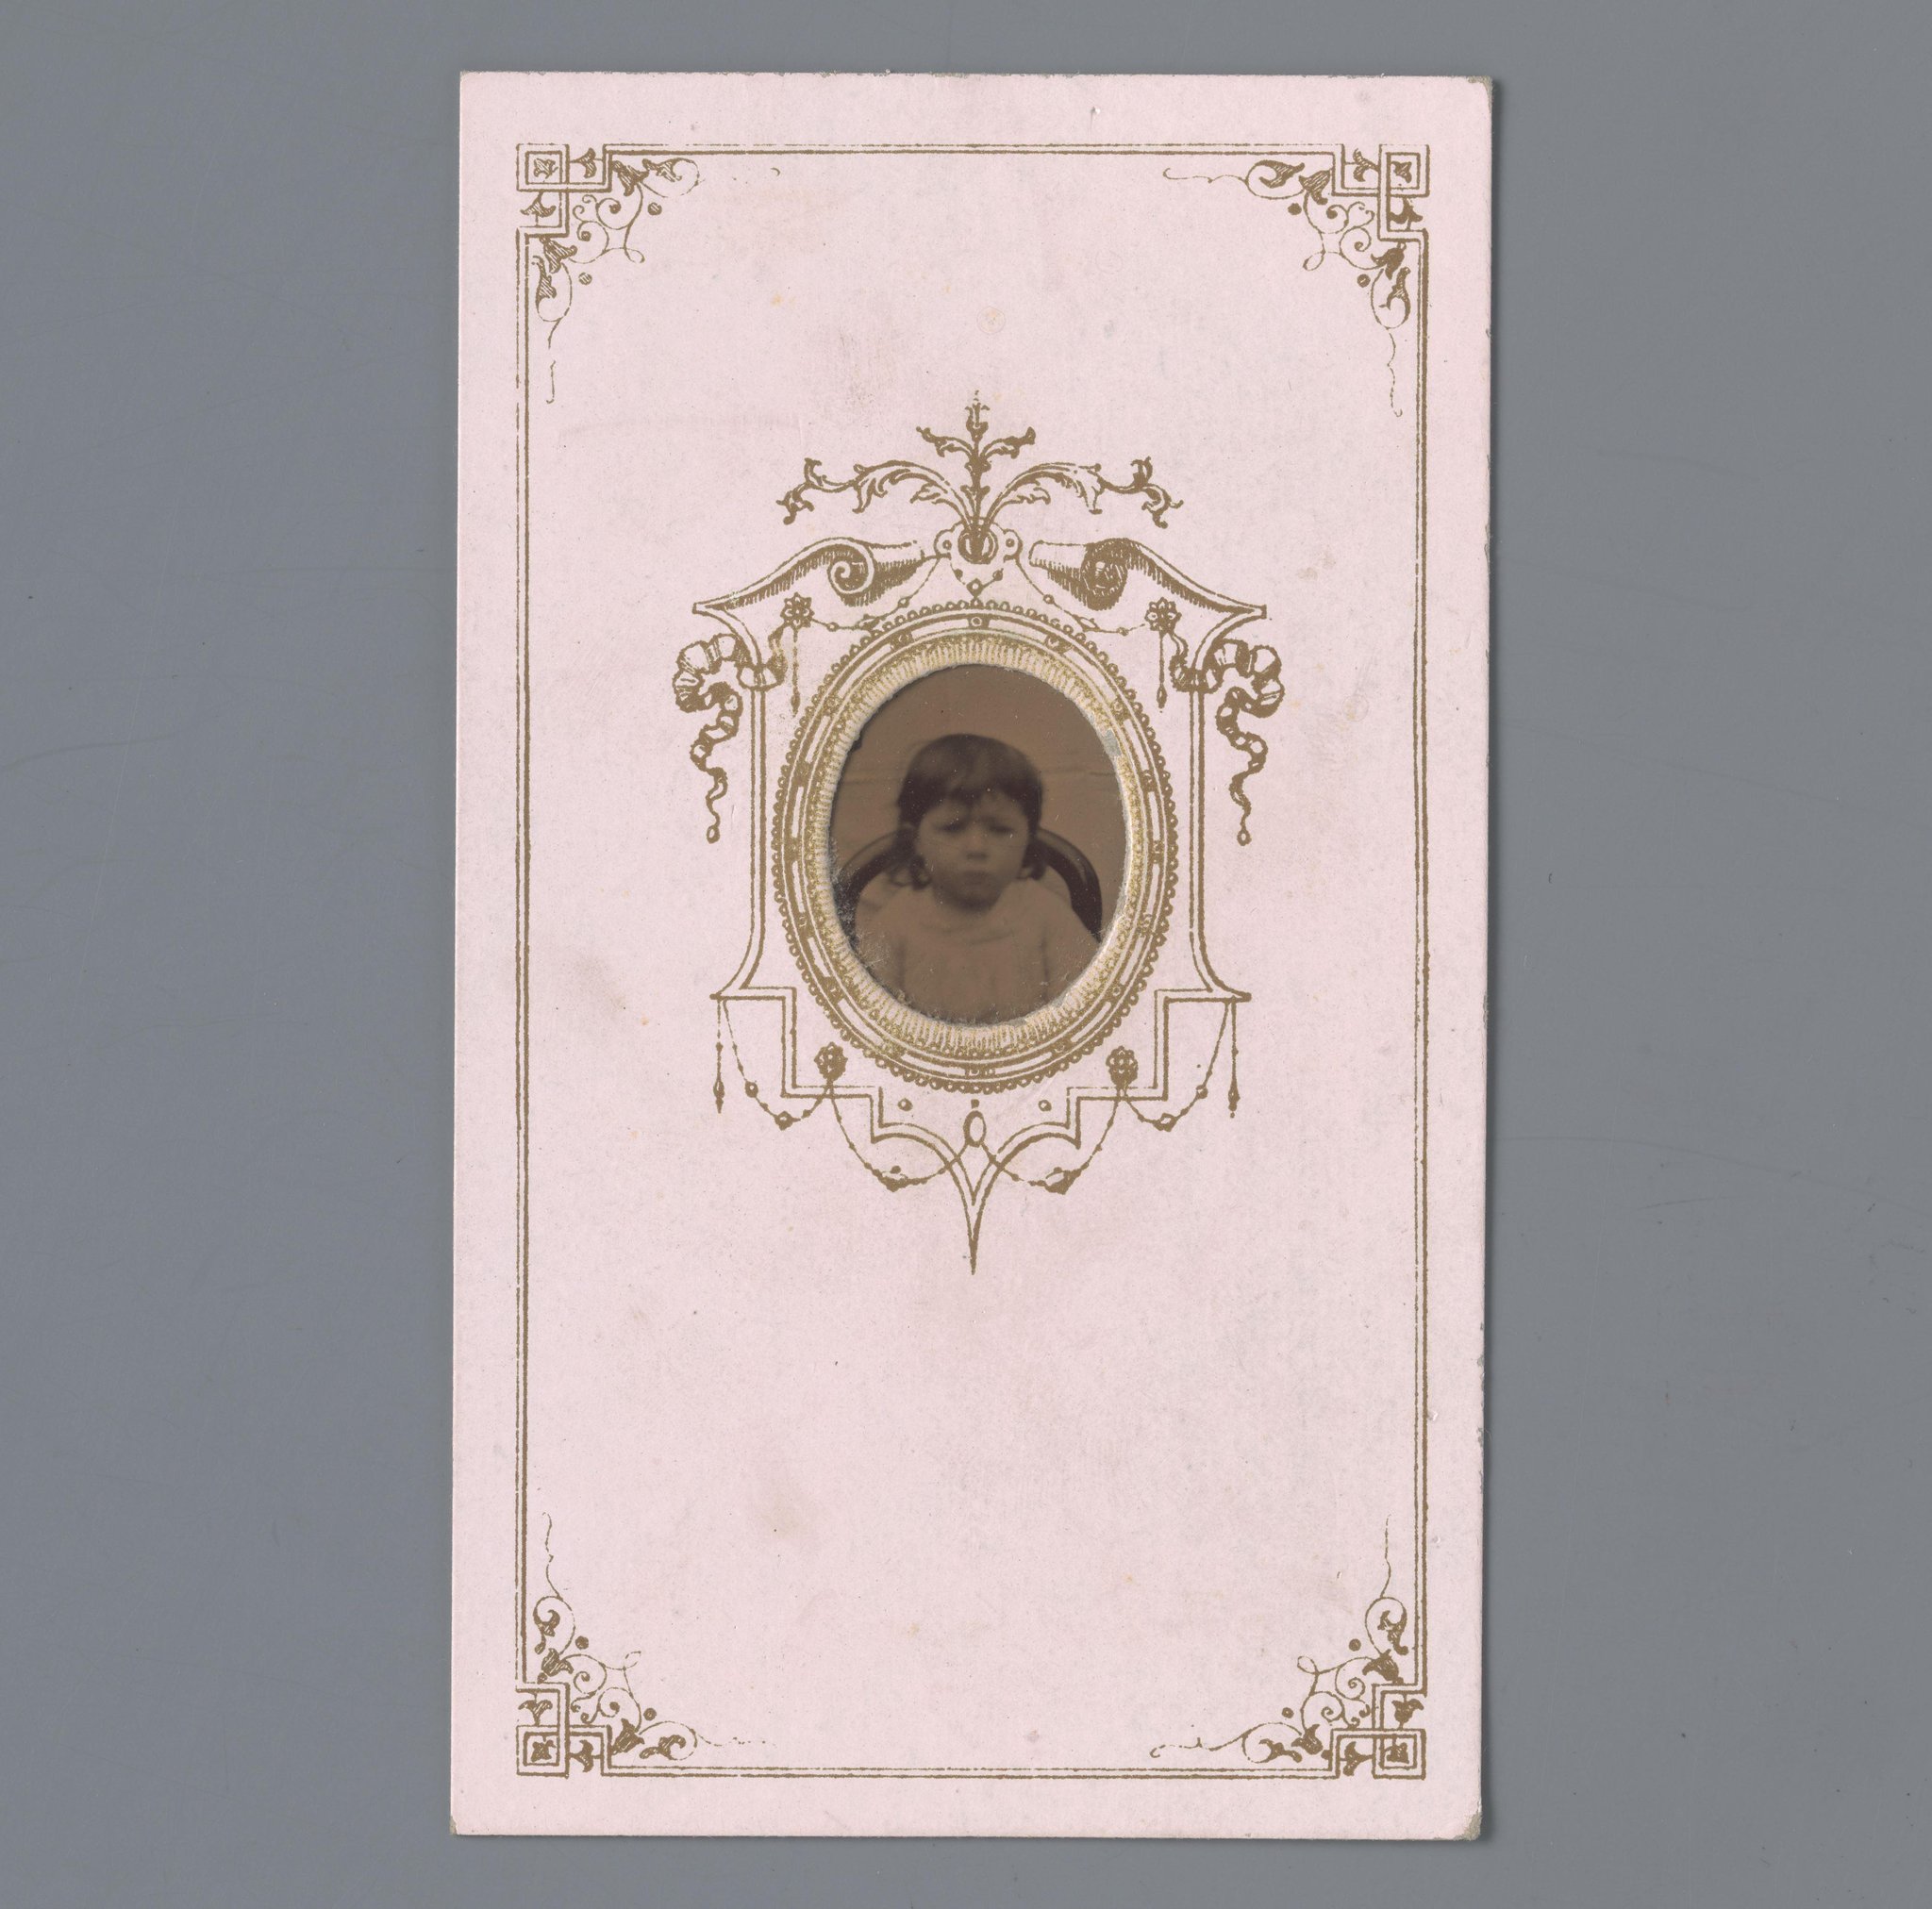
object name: photograph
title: Portret van een onbekend meisje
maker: Anonymous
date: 1855-1900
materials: cardboard, iron, paper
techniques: ferrotyping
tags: historical persons - bb - woman, girl (child between toddler and youth)